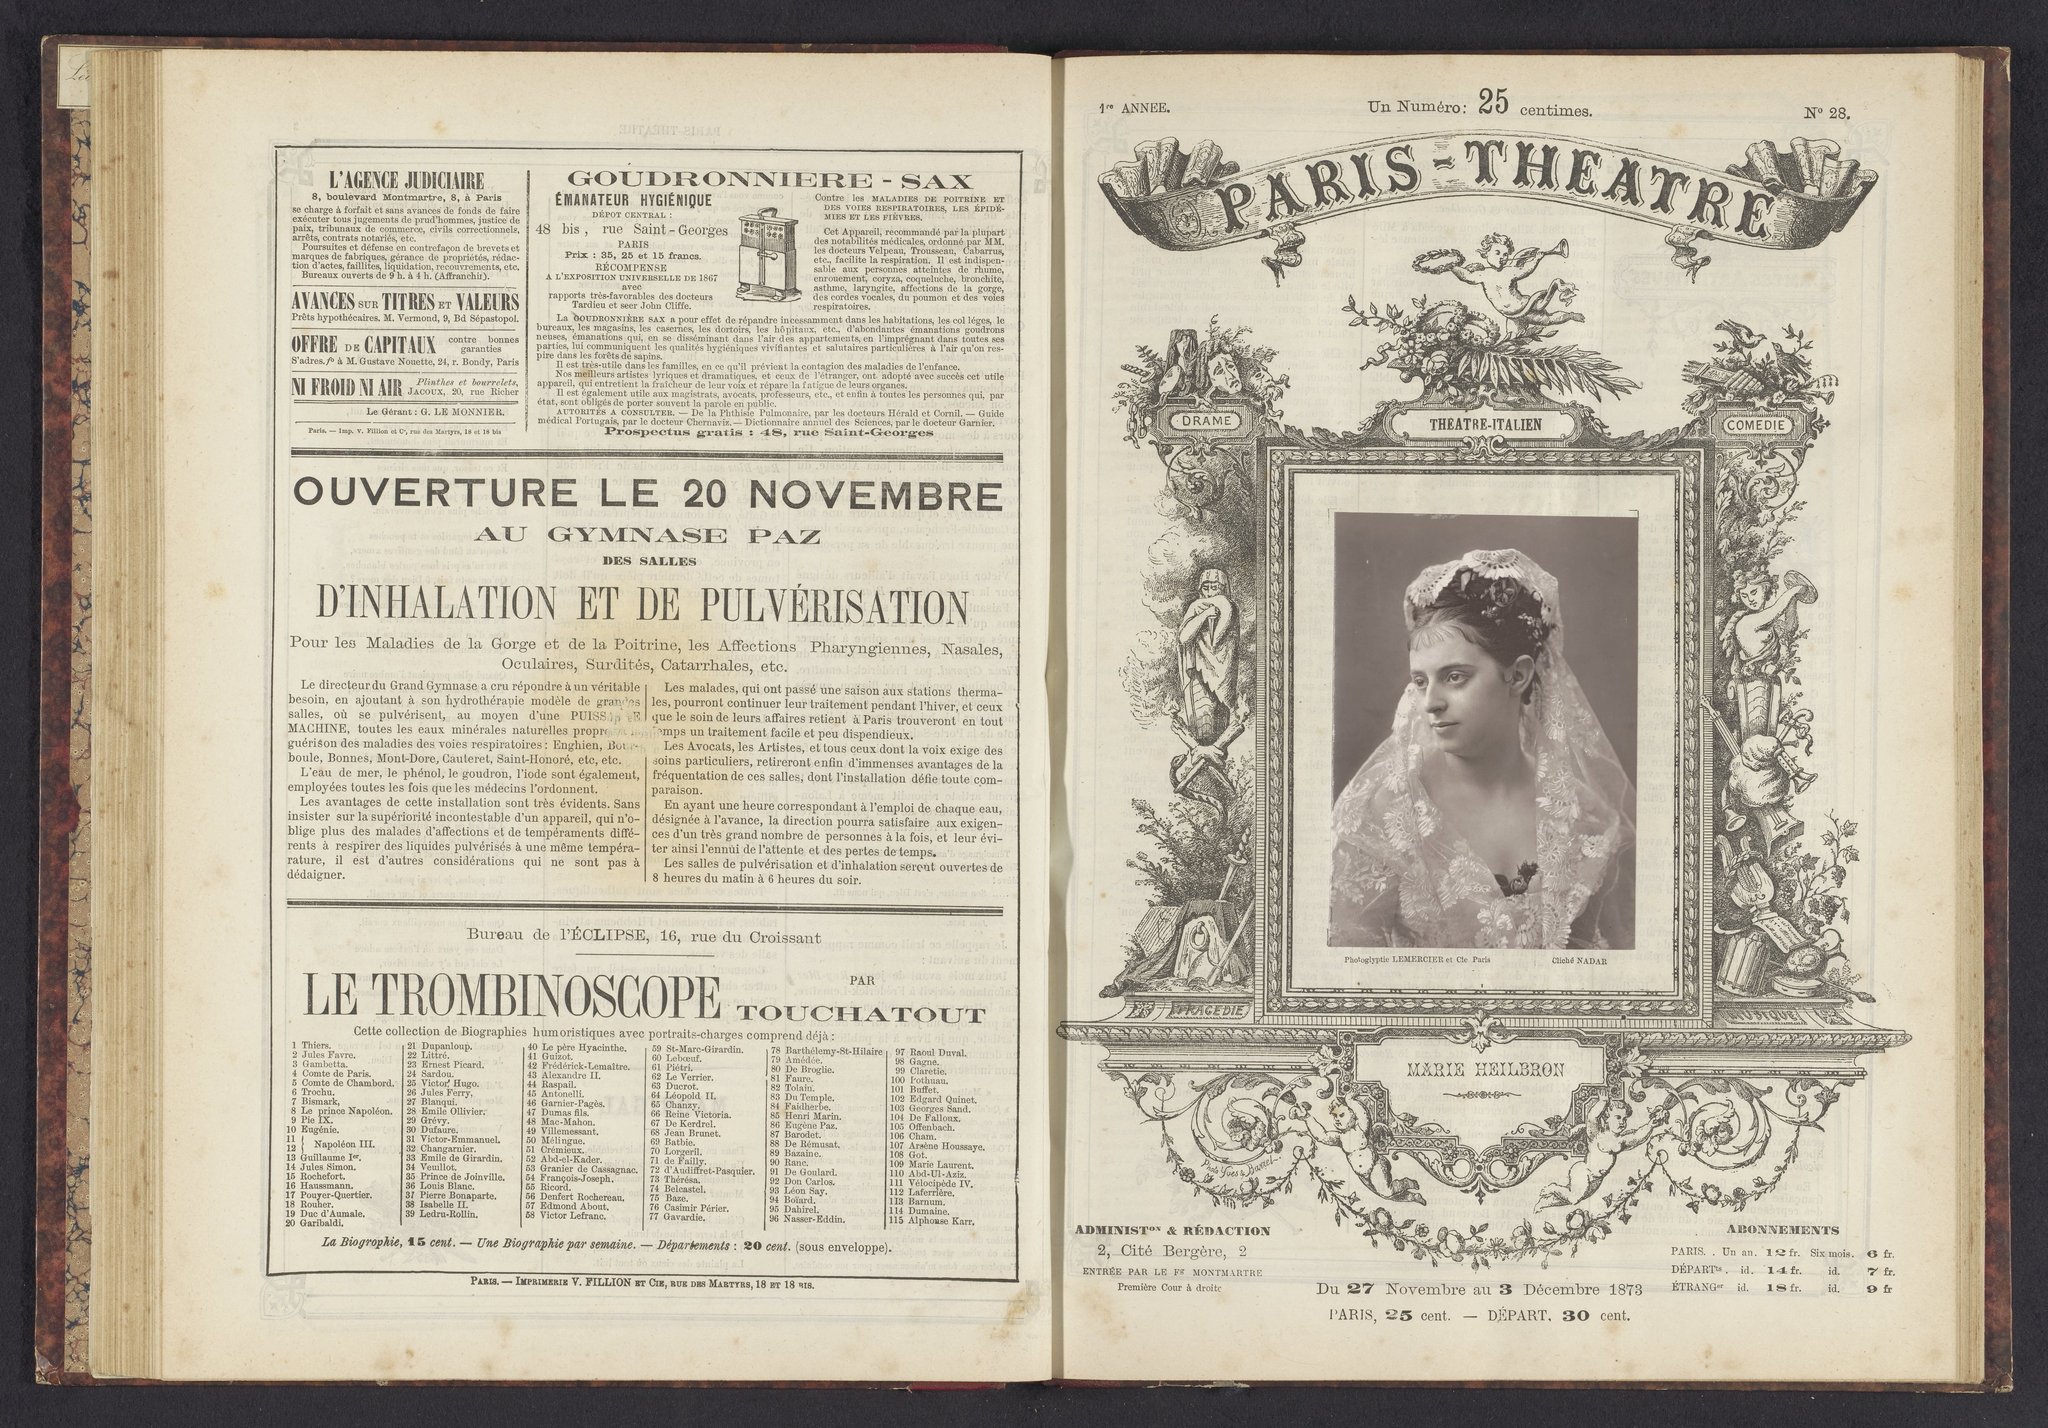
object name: photomechanical print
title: Marie Heilbron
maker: félix nadar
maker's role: ballonvaarder, fotograaf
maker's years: 1820-1910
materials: paper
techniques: woodburytype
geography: france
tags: portrait of opera-singer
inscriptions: inscription: ‘Du 27 Novembre au 3 Décembre 1873.’, number: ‘No 28.’